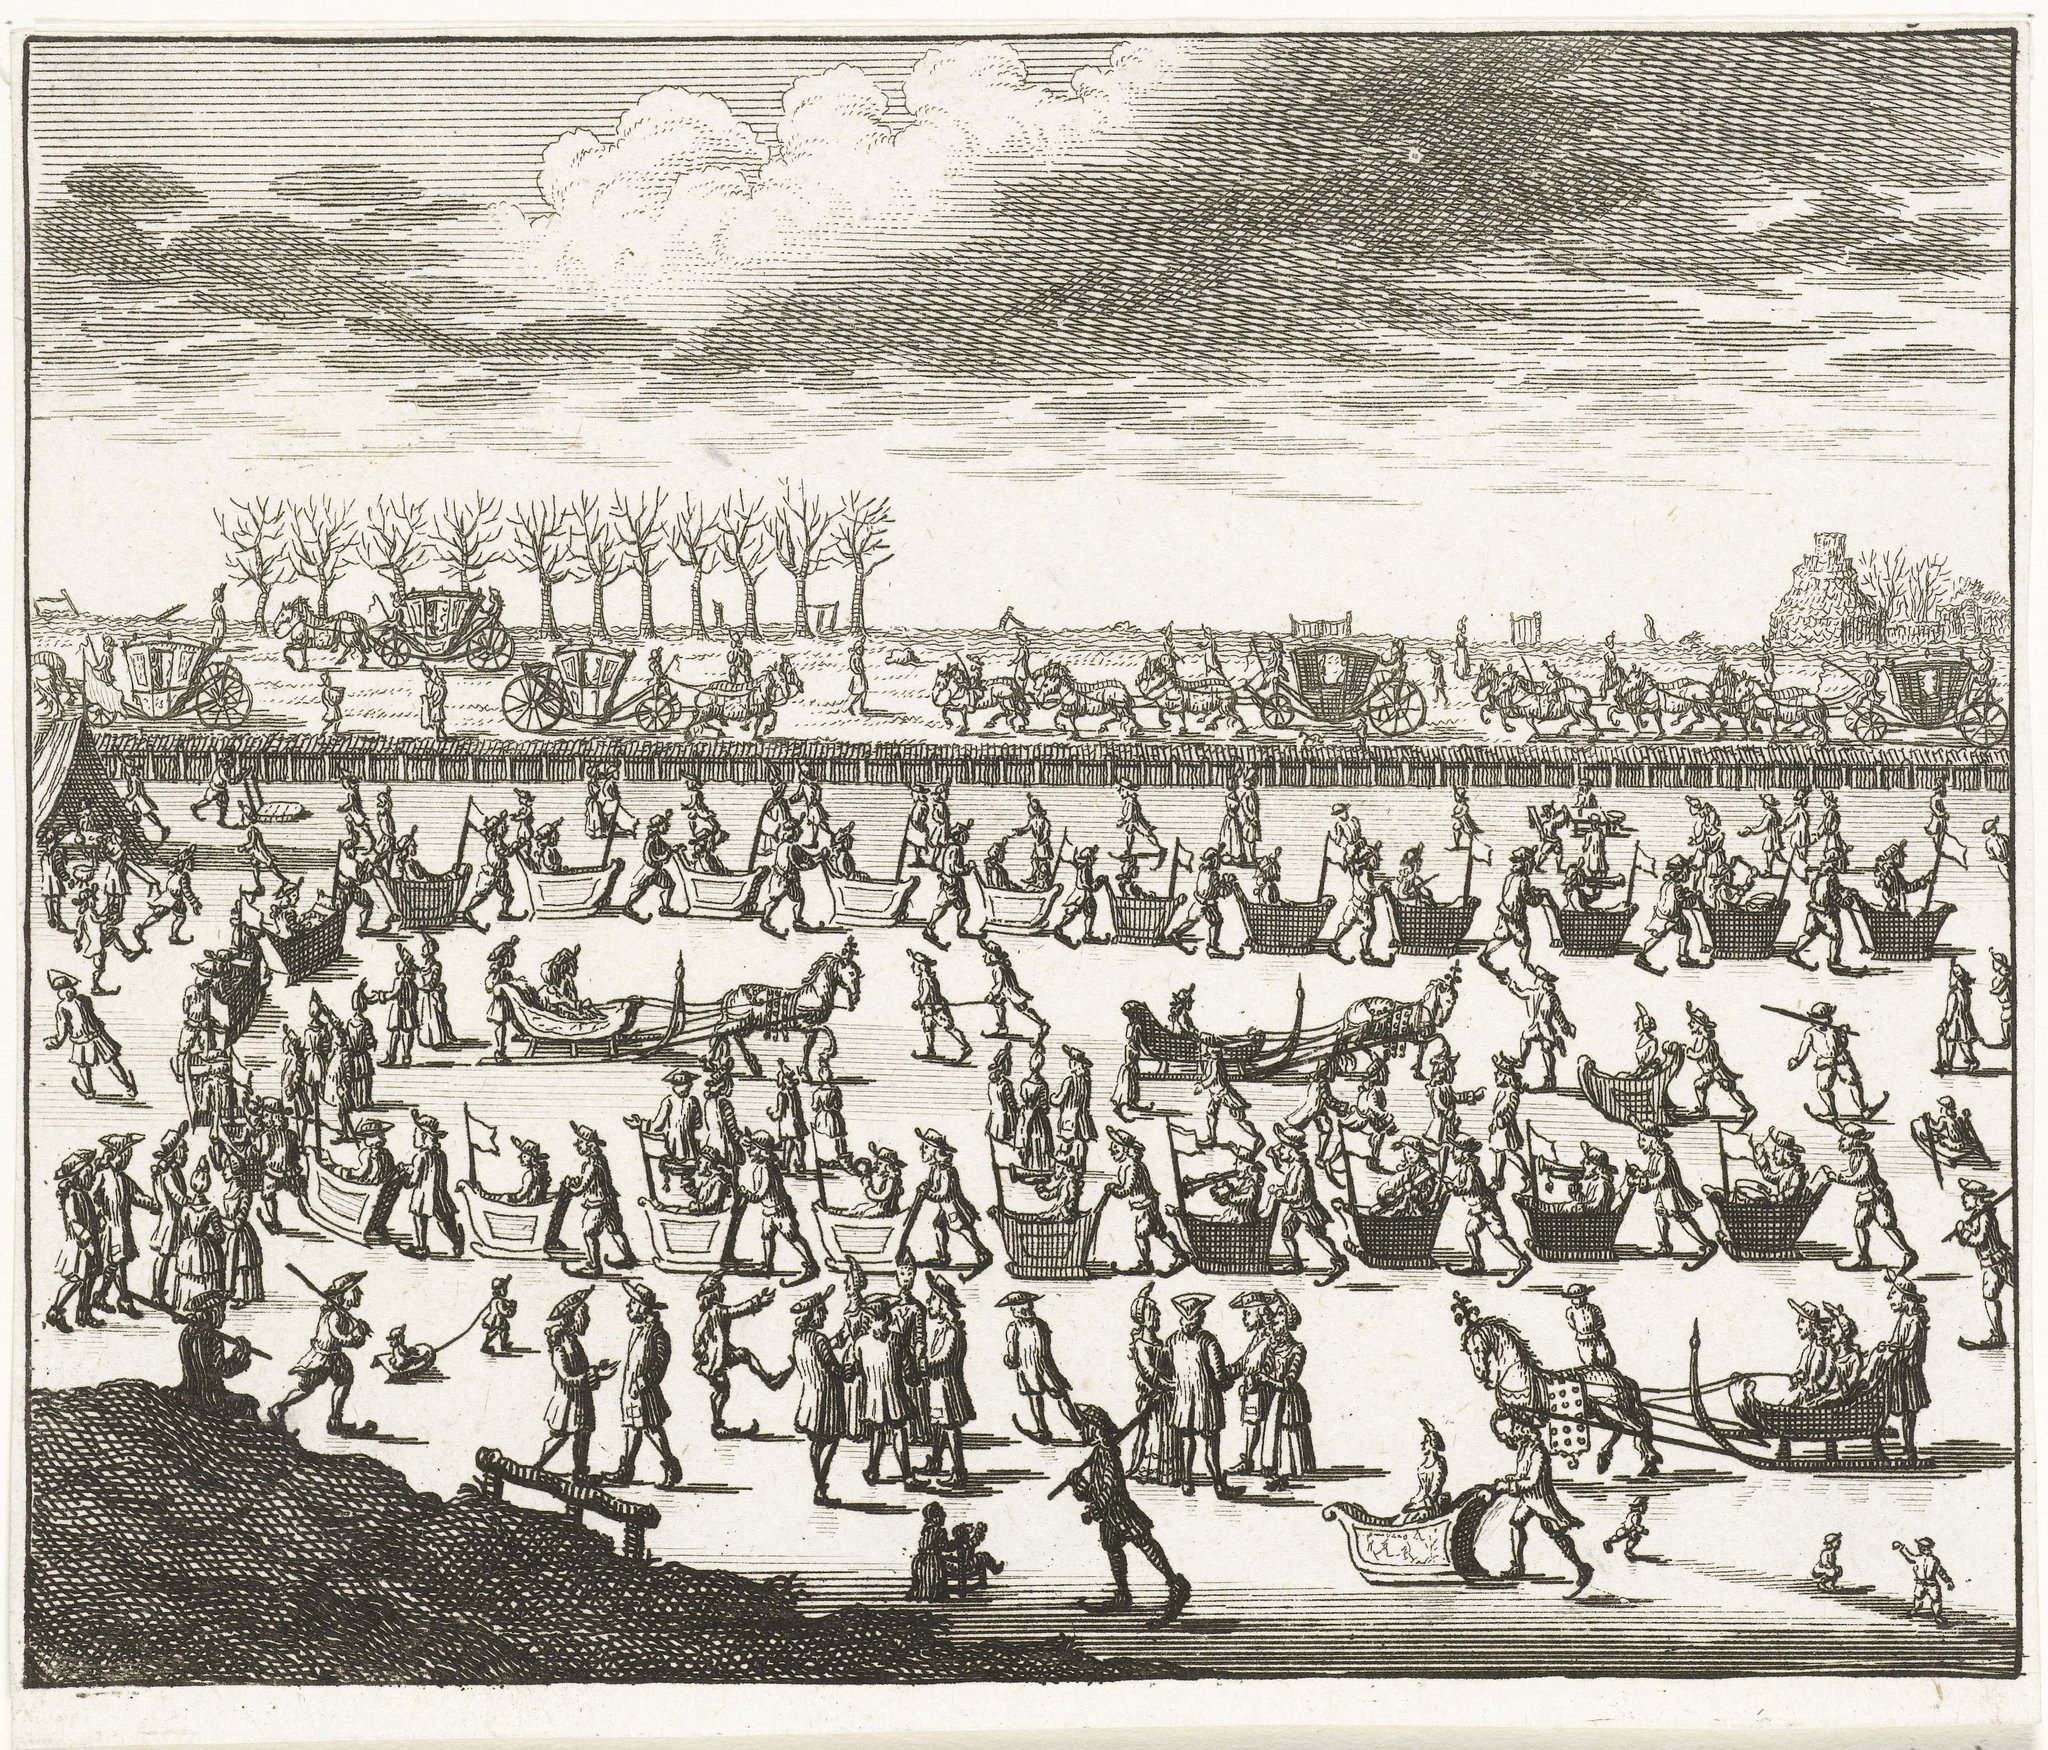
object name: print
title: IJsvermaak, 1714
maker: Anonymous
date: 1714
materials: paper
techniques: etching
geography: northern netherlands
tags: vienna, public festivities at birth of royal persons, sledge, sleigh (winter sports), utrecht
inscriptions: collector's mark: Lugt 2228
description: IJsvermaak, stoet van sledes met gasten op het ijs, 1714. Onderdeel van een groep van twaalf illustraties van de feestelijkheden georganiseerd in Utrecht in 1714 door de Portugese graaf Joao Gomes da Silva conde de Tarouca ter ere van de geboorte van twee Portugese prinsjes van koning Johan V.